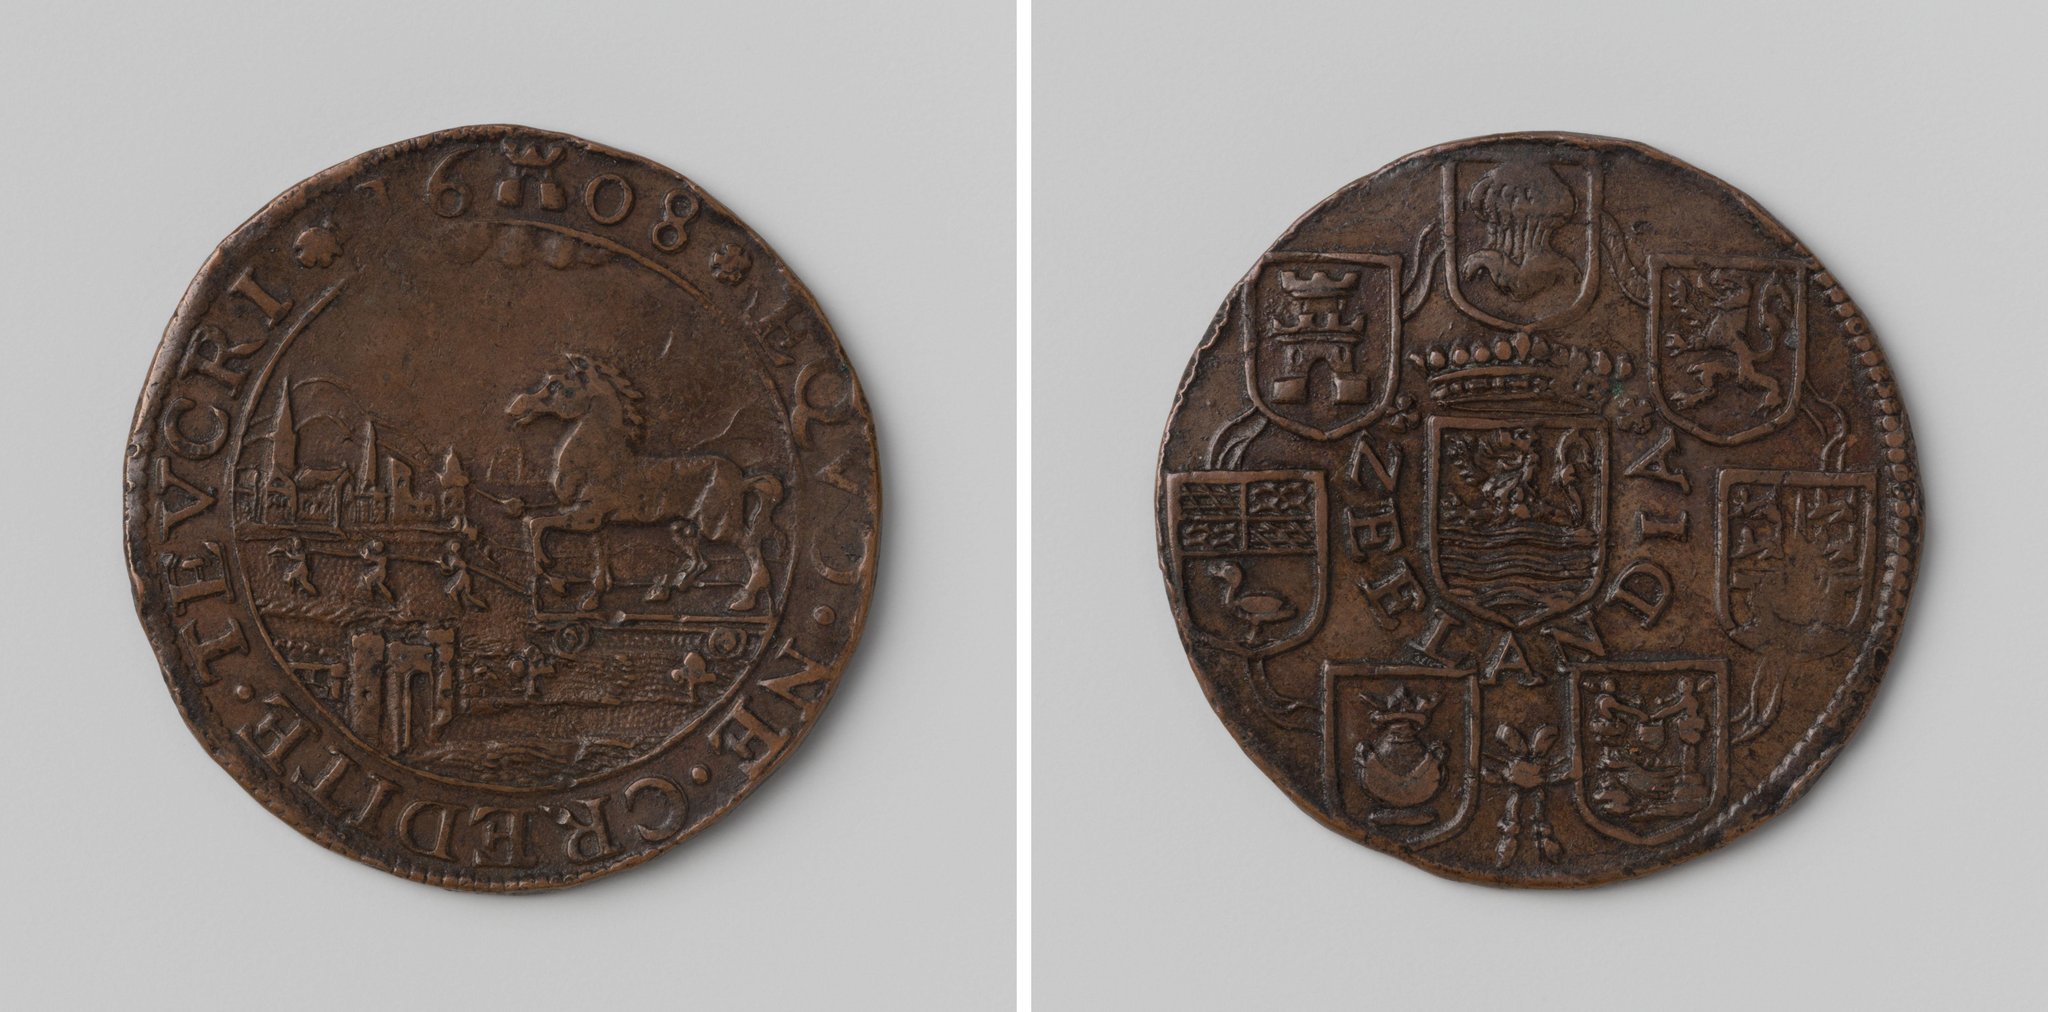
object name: jeton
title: Waarschuwing tegen de voorstellen voor een bestand tussen de Republiek en Spanje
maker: Anonymous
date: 1608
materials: copper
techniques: striking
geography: middelburg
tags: zeeland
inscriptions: circumscription: ‘ZEELANDIA’, circumscription: ‘EQVO NE CREDITE TEVCRI / 1608’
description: Koperen penning. Voorzijde: binnenhalen van het paard van Troje binnen omschrift. Keerzijde: gekroond wapenschild binnen omschrift en rand van zeven met lint verbonden wapenschilden.